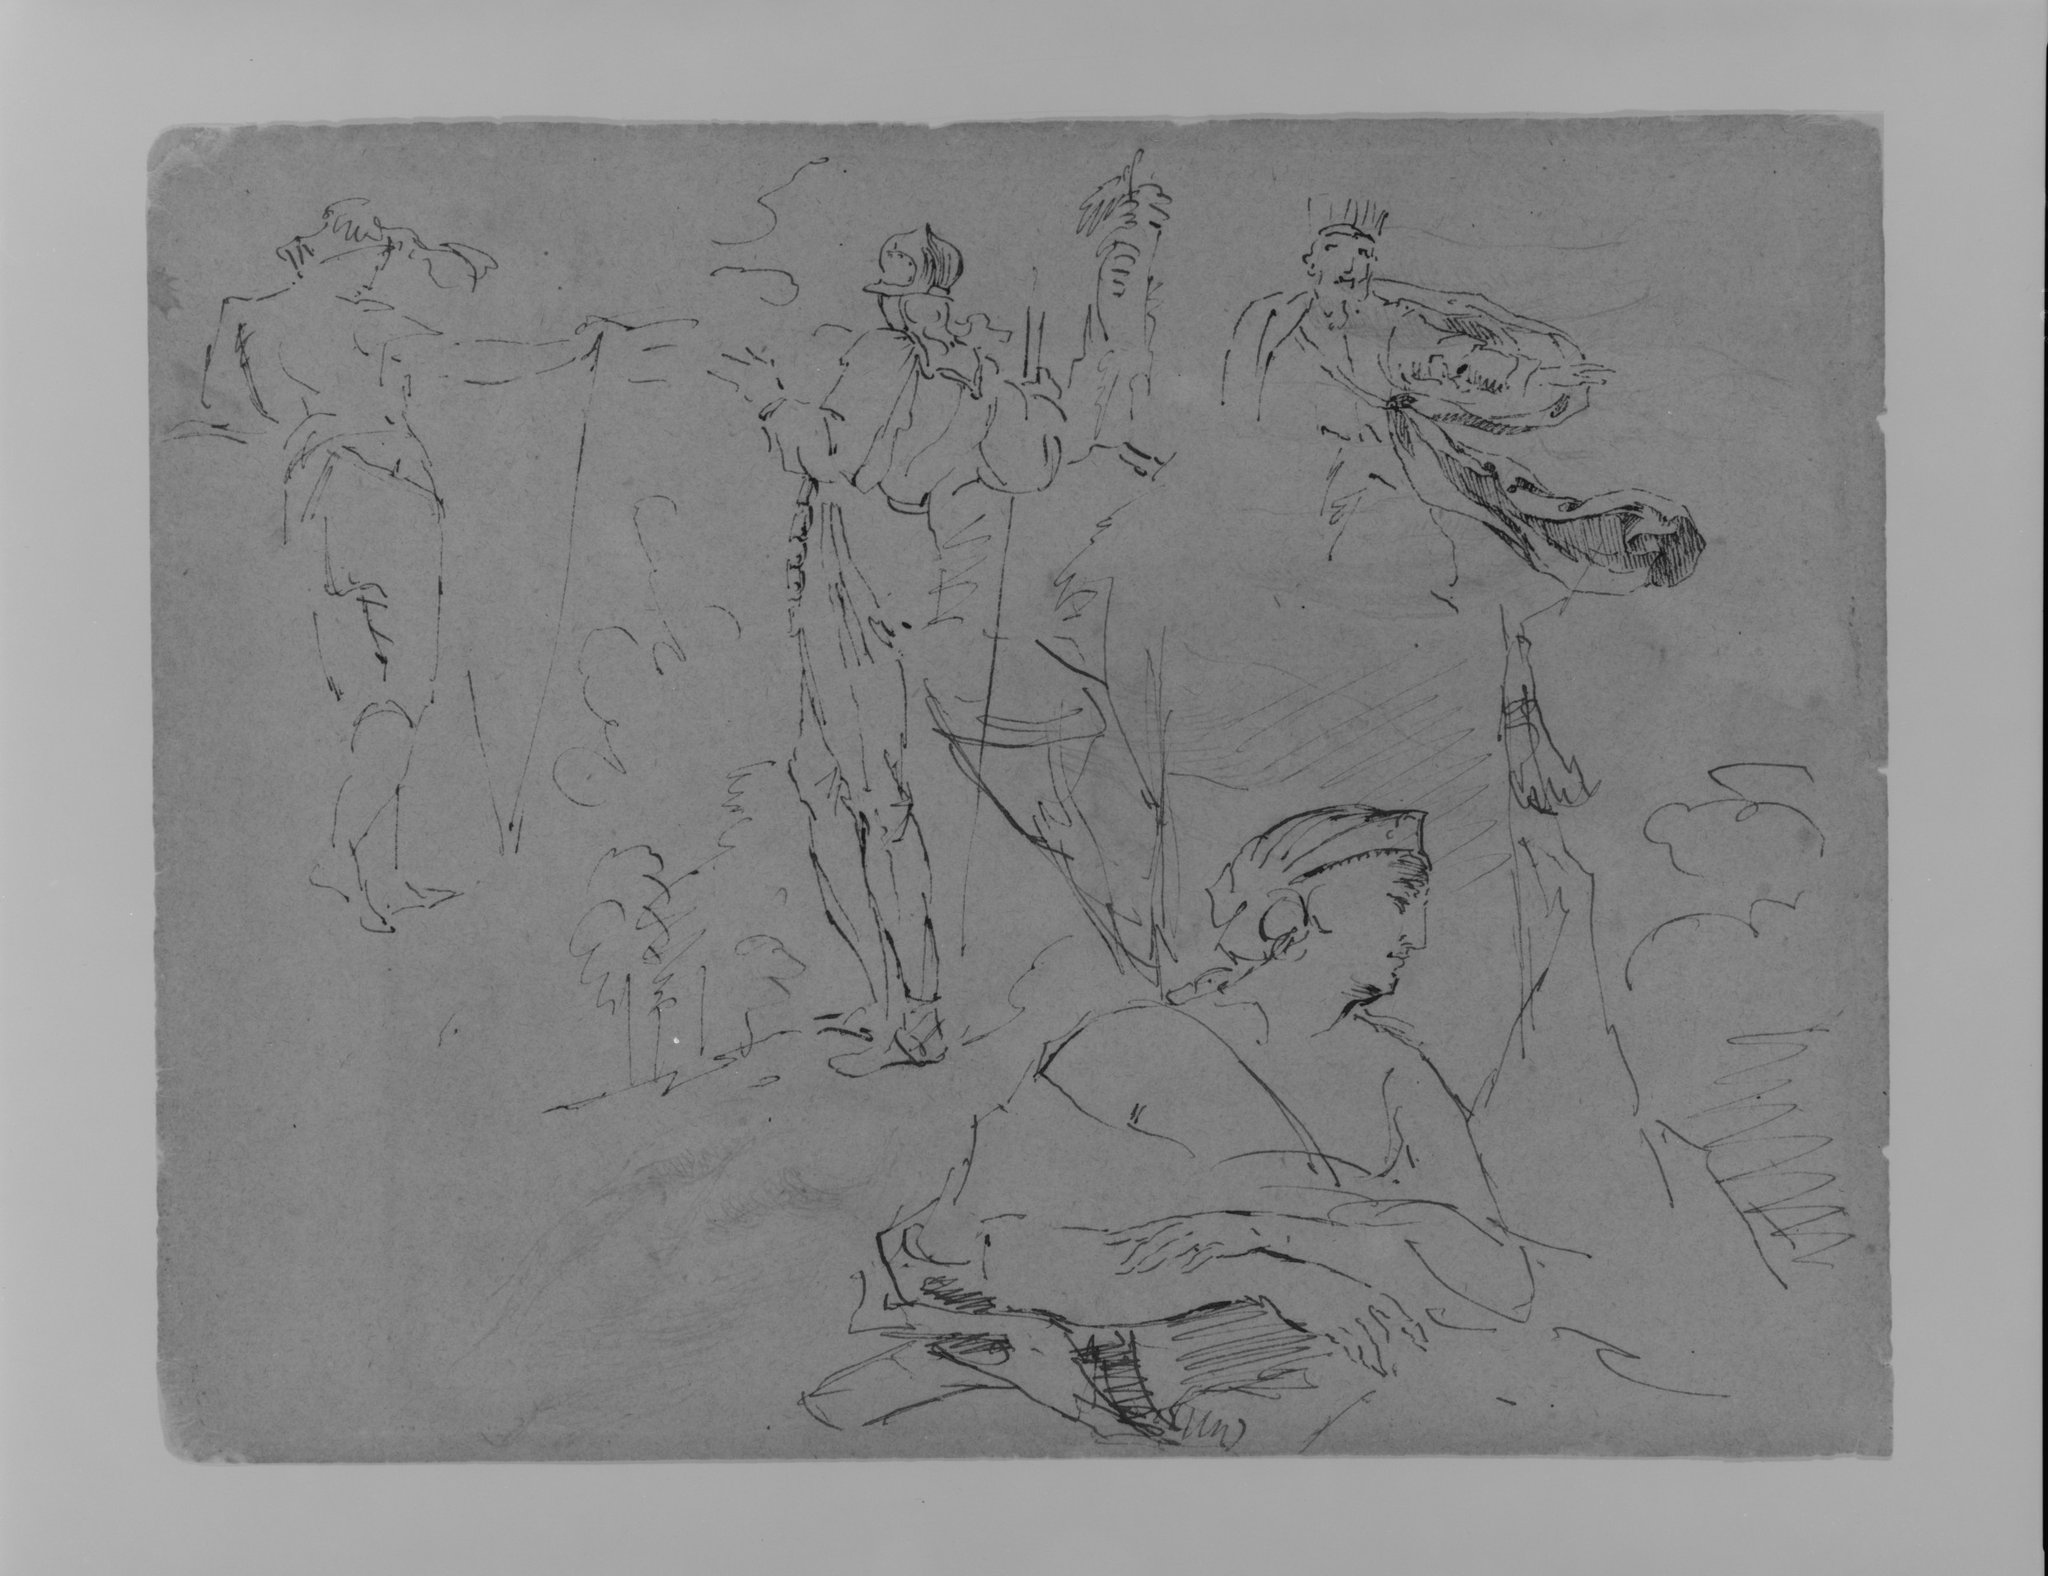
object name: drawing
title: Sketches of Two Sentry Types; Male and Female Monarch Types [male possibly King Lear] (from Sketchbook)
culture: american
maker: thomas sully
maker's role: artist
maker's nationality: american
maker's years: 1783-1872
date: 1810-1820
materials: ink, paper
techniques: wash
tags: men,women